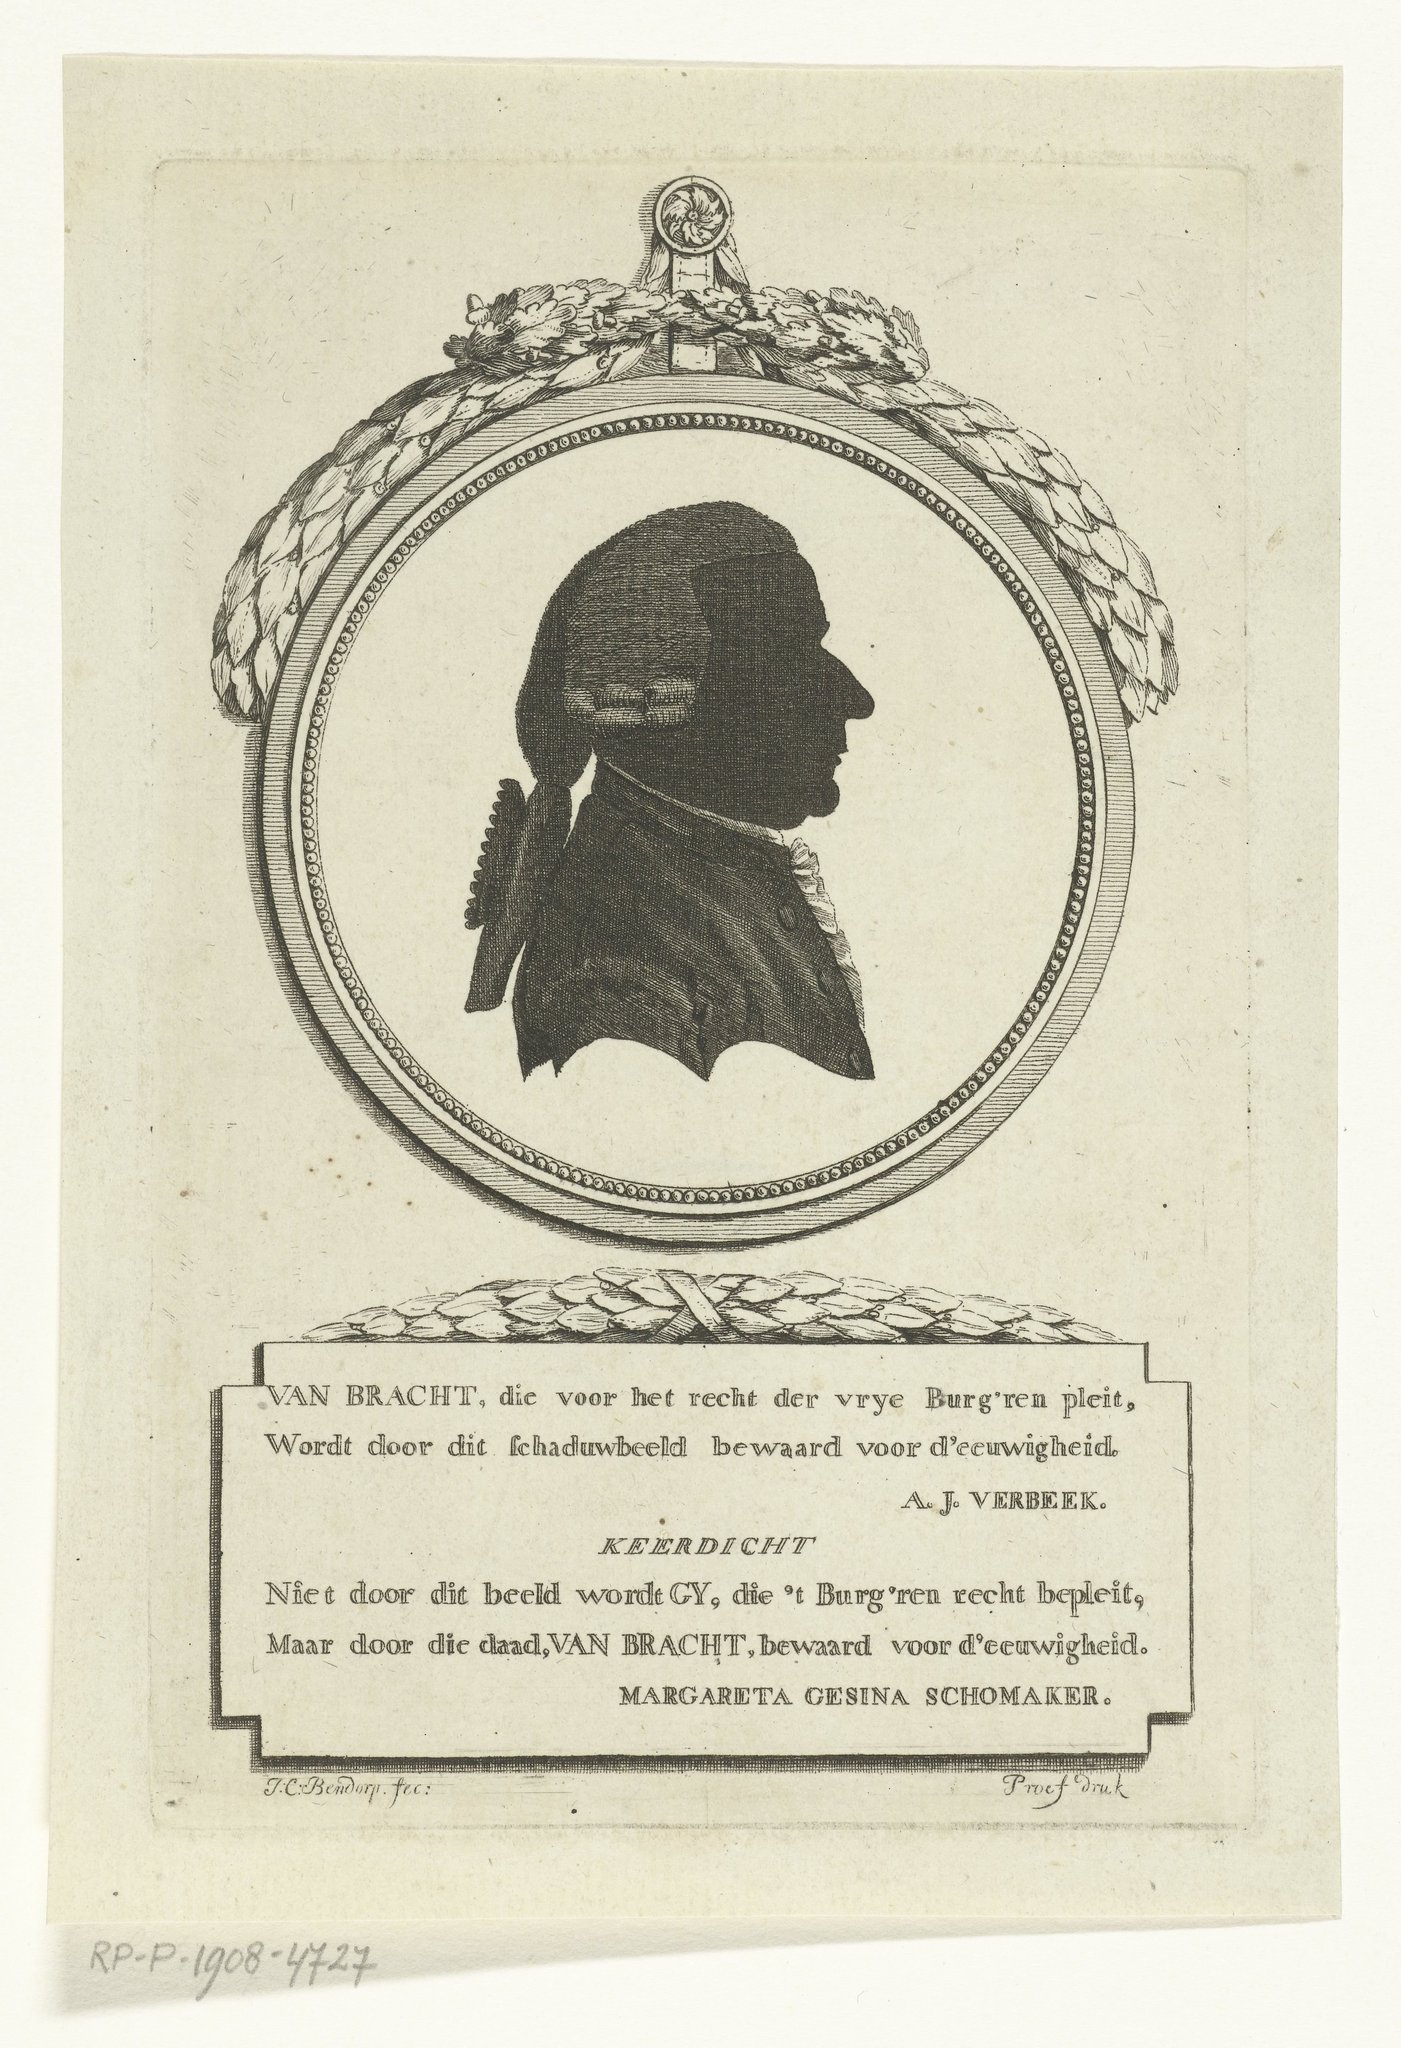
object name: print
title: Silhouetportret van Van Bracht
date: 1776-1849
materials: paper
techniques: etching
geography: netherlands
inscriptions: collector's mark: Lugt 2228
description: Portret in silhouet van Van Bracht in medaillon met guirlanden. Twee versen op tablet onder de voorstelling roemen zijn inzet voor de vrijheid van vaderlandse burgers.